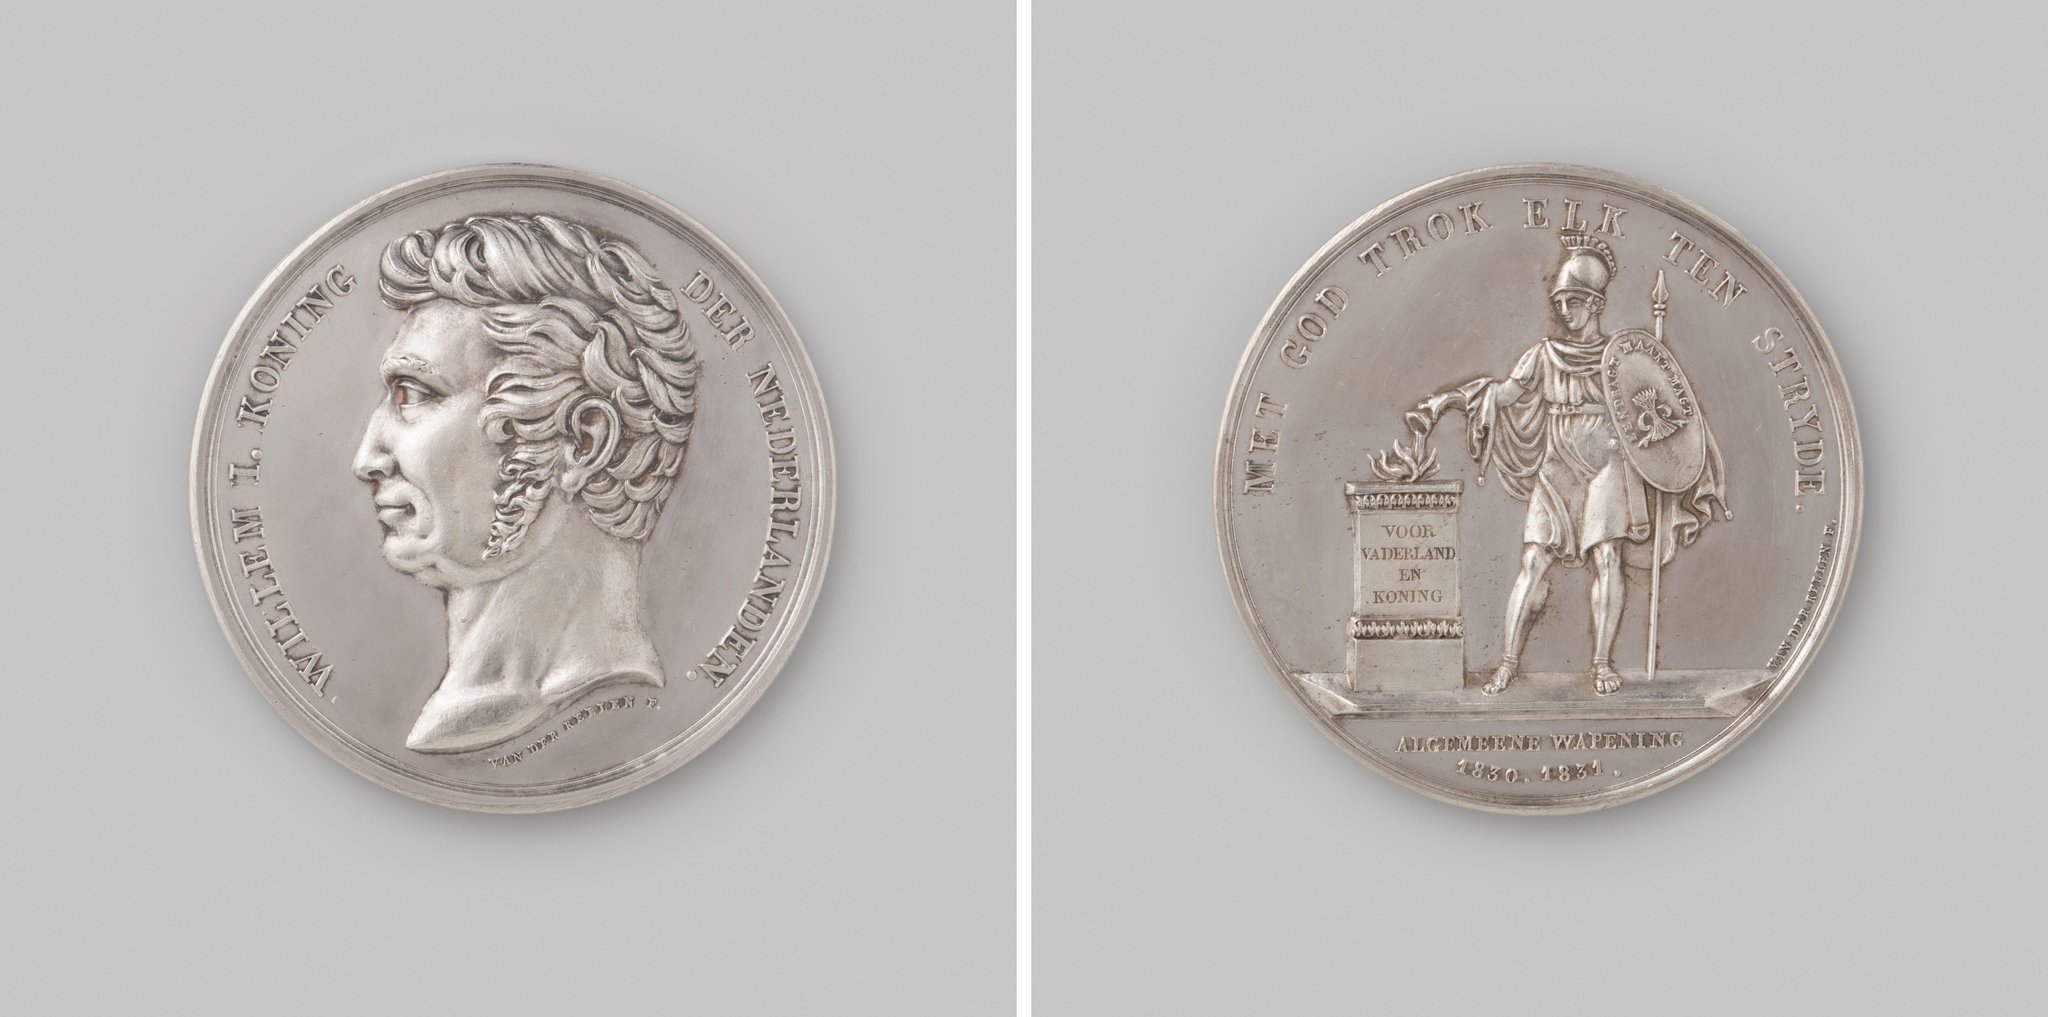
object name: history medal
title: Algemene bewapening in de noordelijke Nederlanden, ter ere van Willem I Frederik, koning der Nederlanden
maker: david van der kellen (1804-1879)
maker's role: die cutter, draughtsman, print maker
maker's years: 1804-1879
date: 1831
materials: silver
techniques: striking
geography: utrecht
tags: william i of the netherlands, netherlands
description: Zilveren penning. Voorzijde: borststuk man binnen omschrift. Keerzijde: gehelmde krijger met speer enwapenschild verricht plengoffer boven brandend altaar, waarvan sokkel opschrift draagtbinnen omschrift; afsnede: opschrift